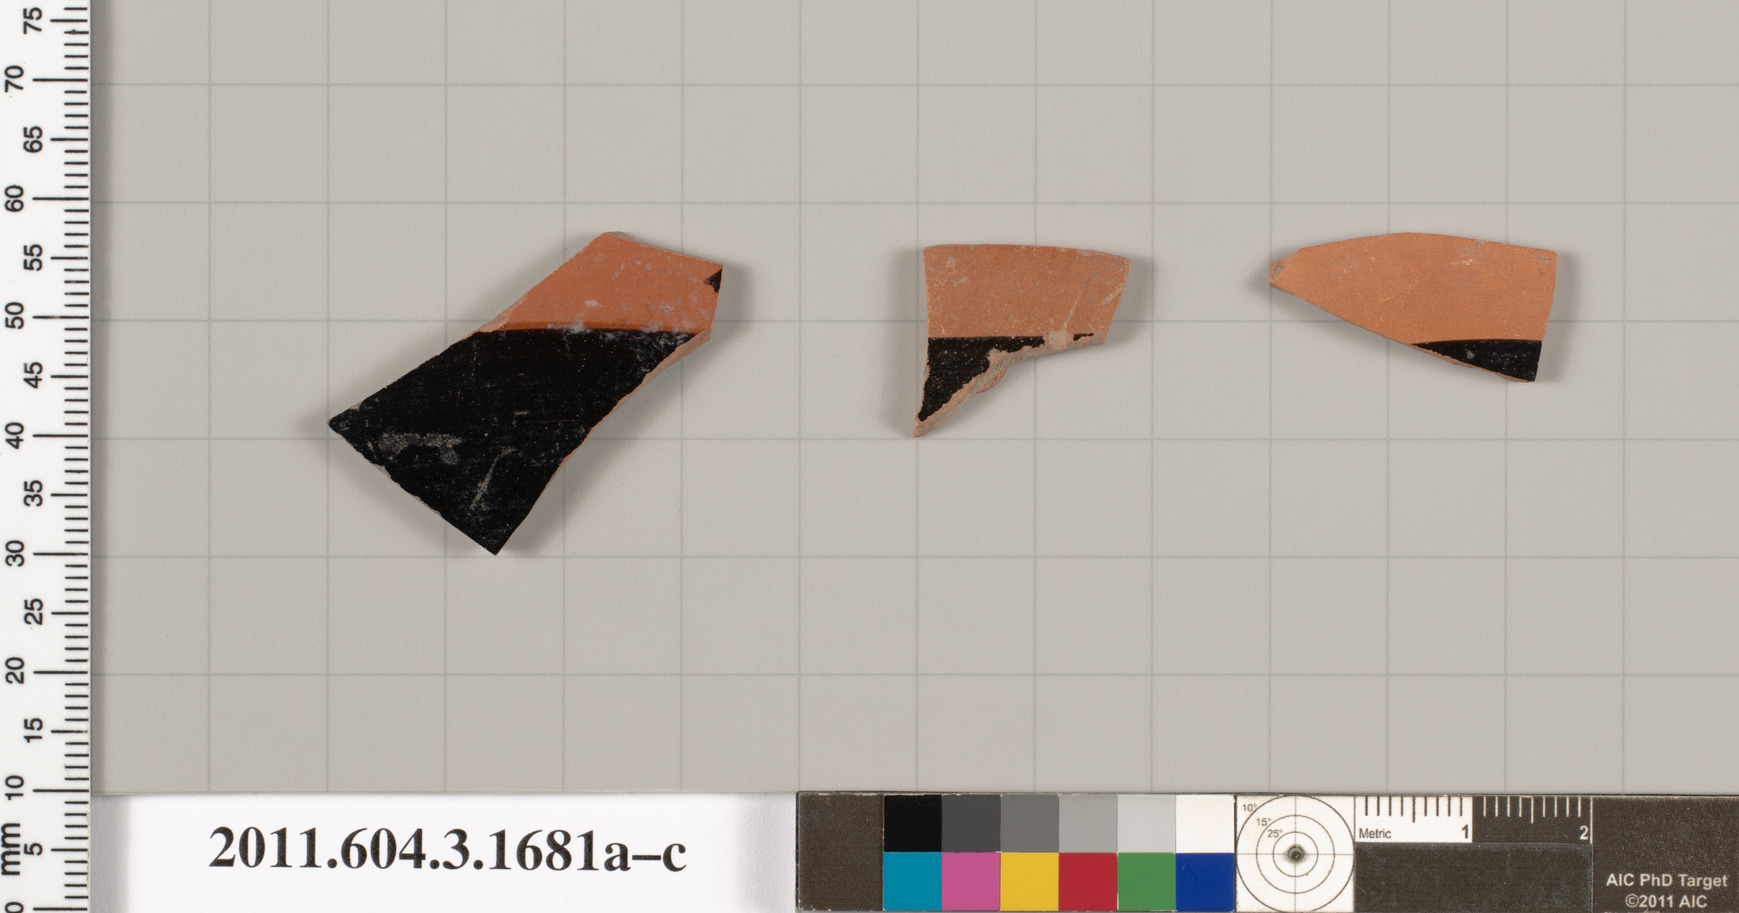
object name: kylix fragment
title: Terracotta fragments of kylikes: Band or lip cups (drinking cups)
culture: greek, attic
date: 550-526 BCE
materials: terracotta